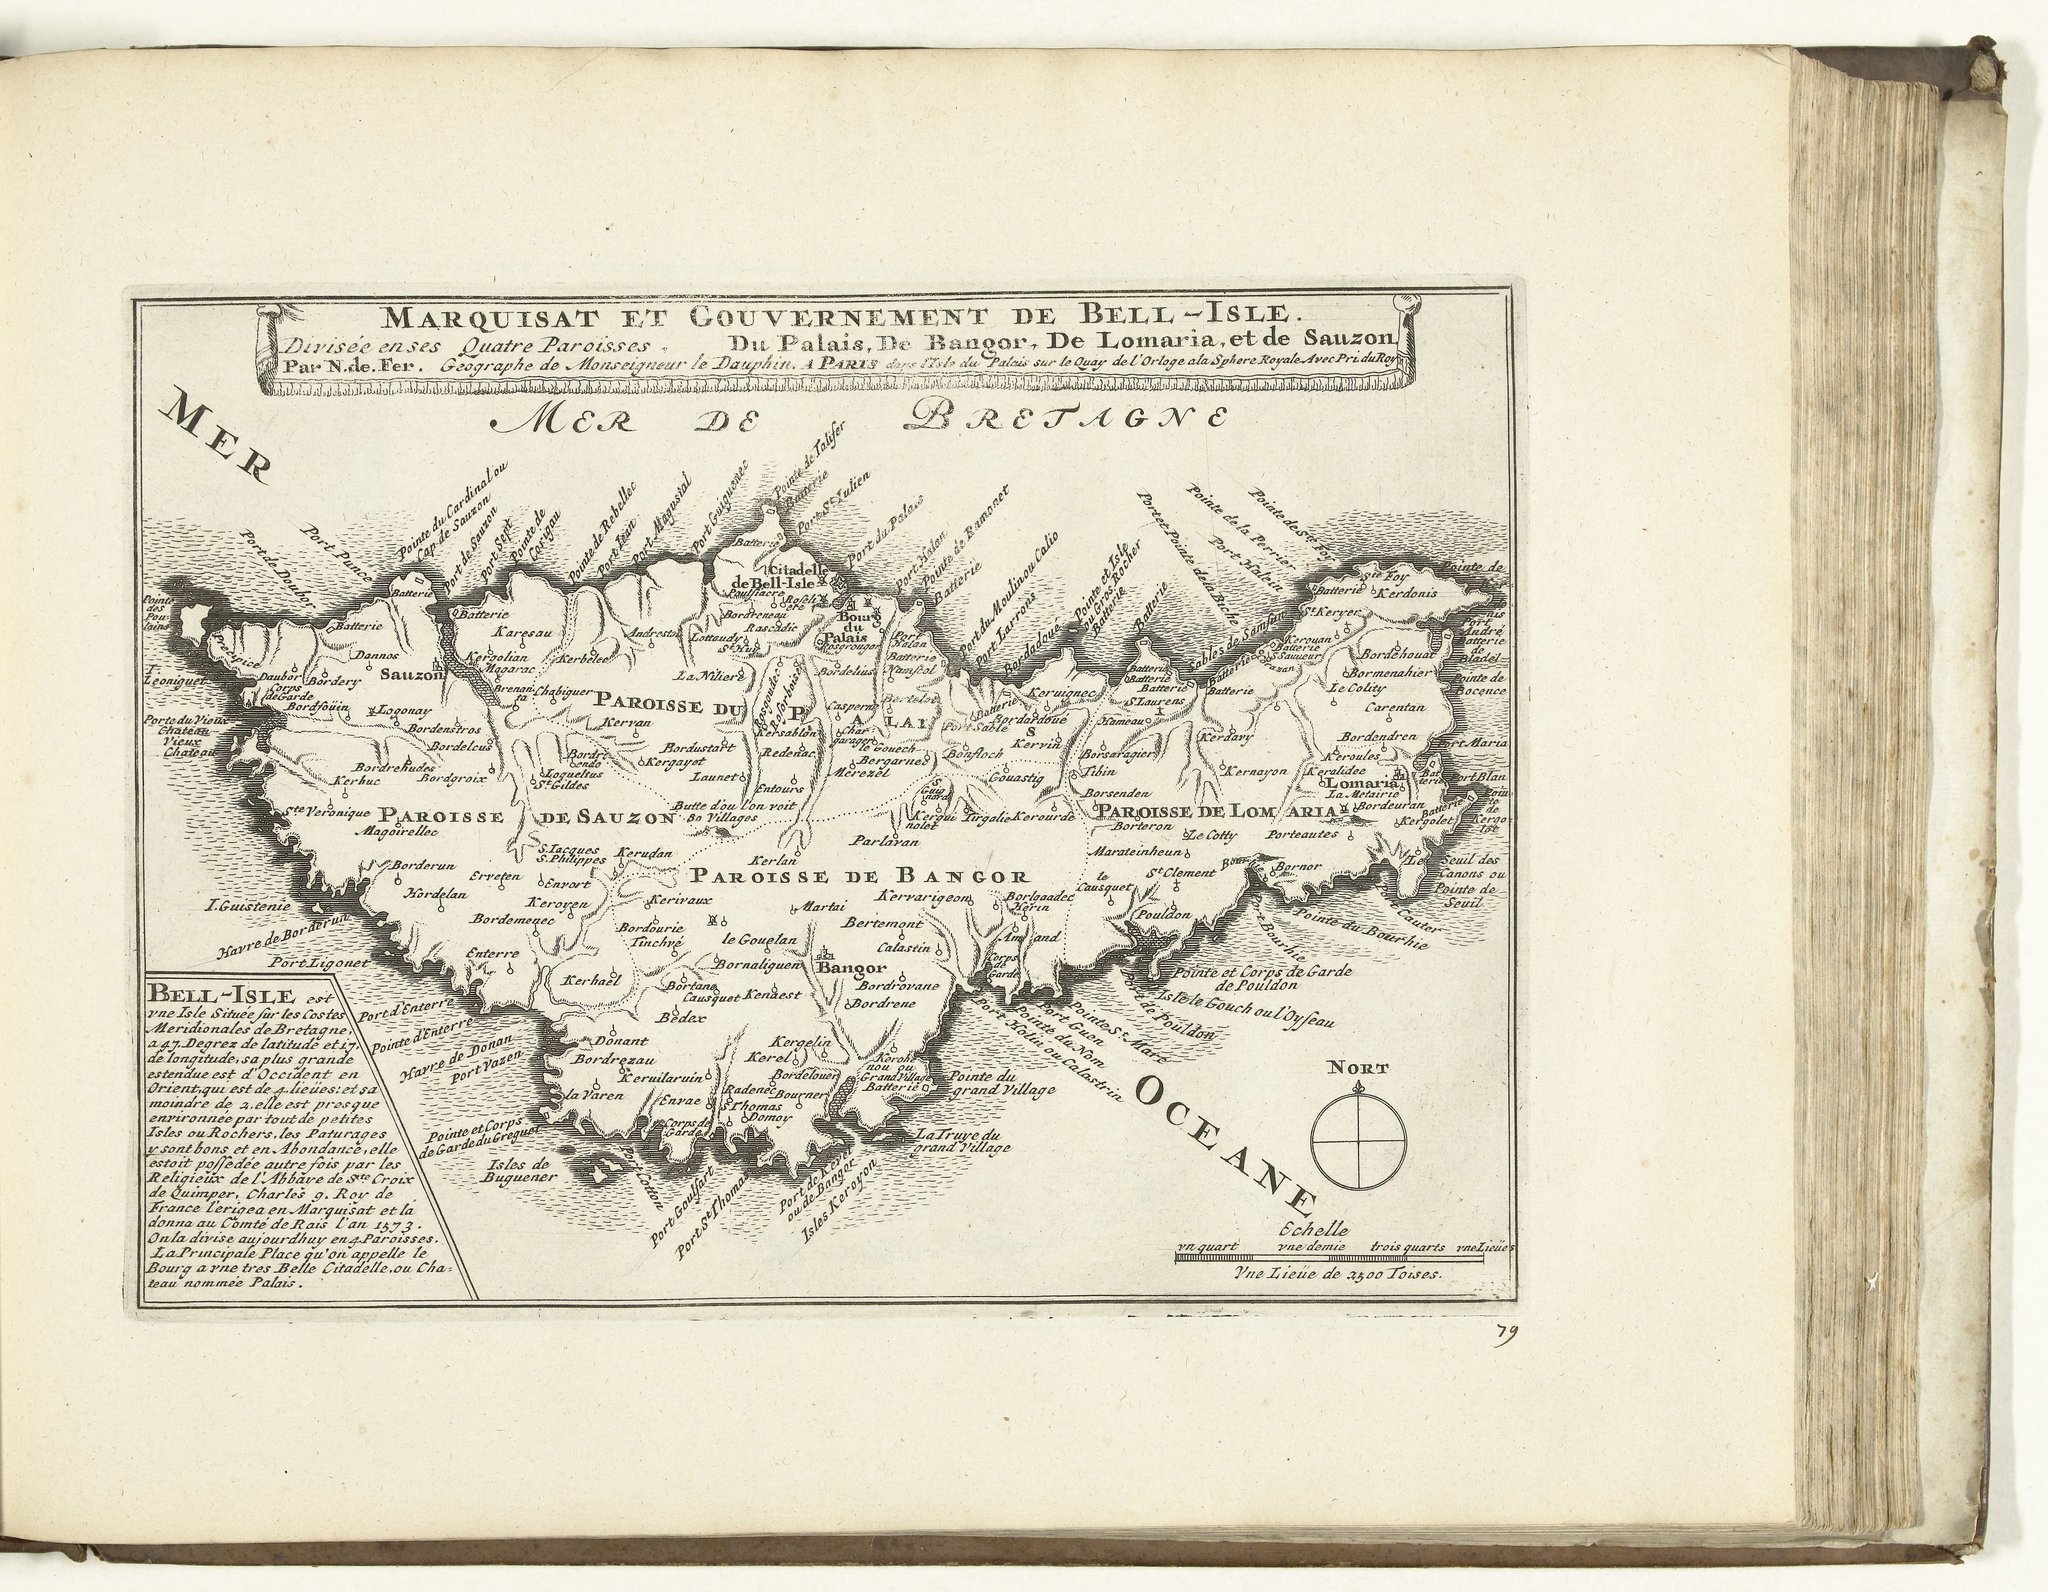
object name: print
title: Les Forces de l'Europe, Asie, Afrique et Amerique (...) Comme aussi les Cartes des Côtes de France et d'Espagne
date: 1726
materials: paper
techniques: etching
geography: paris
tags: maps of separate countries or regions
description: Kaart van de markizaat van Belle Ile. Plaat nr. 79 in deel IV van het prentwerk: Les Forces de l'Europe, Asie, Afrique et Amerique ... Comme aussi les Cartes des Côtes de France et d'Espagne uit 1726, dit eerste deel met 238 met de hand genummerde platen van vermaarde sterke steden en vestingen in het kader van de Spaanse Successieoorlog 1701-1713. Voor het merendeel zijn deze platen gekopieerd naar de anonieme Franse platen van vermaarde sterke steden en vestingen: in Les forces de l'Europe en in: Le theatre de la guerre, dans les Pays-Bas, beide oorspronkelijk uitgegeven door Nicolas de Fer te Parijs (1693-1697) in het kader van de Negenjarige Oorlog. Titel en opschriften in het Frans. Rechtsonder sporen van het weggepolijste nummer: 229.